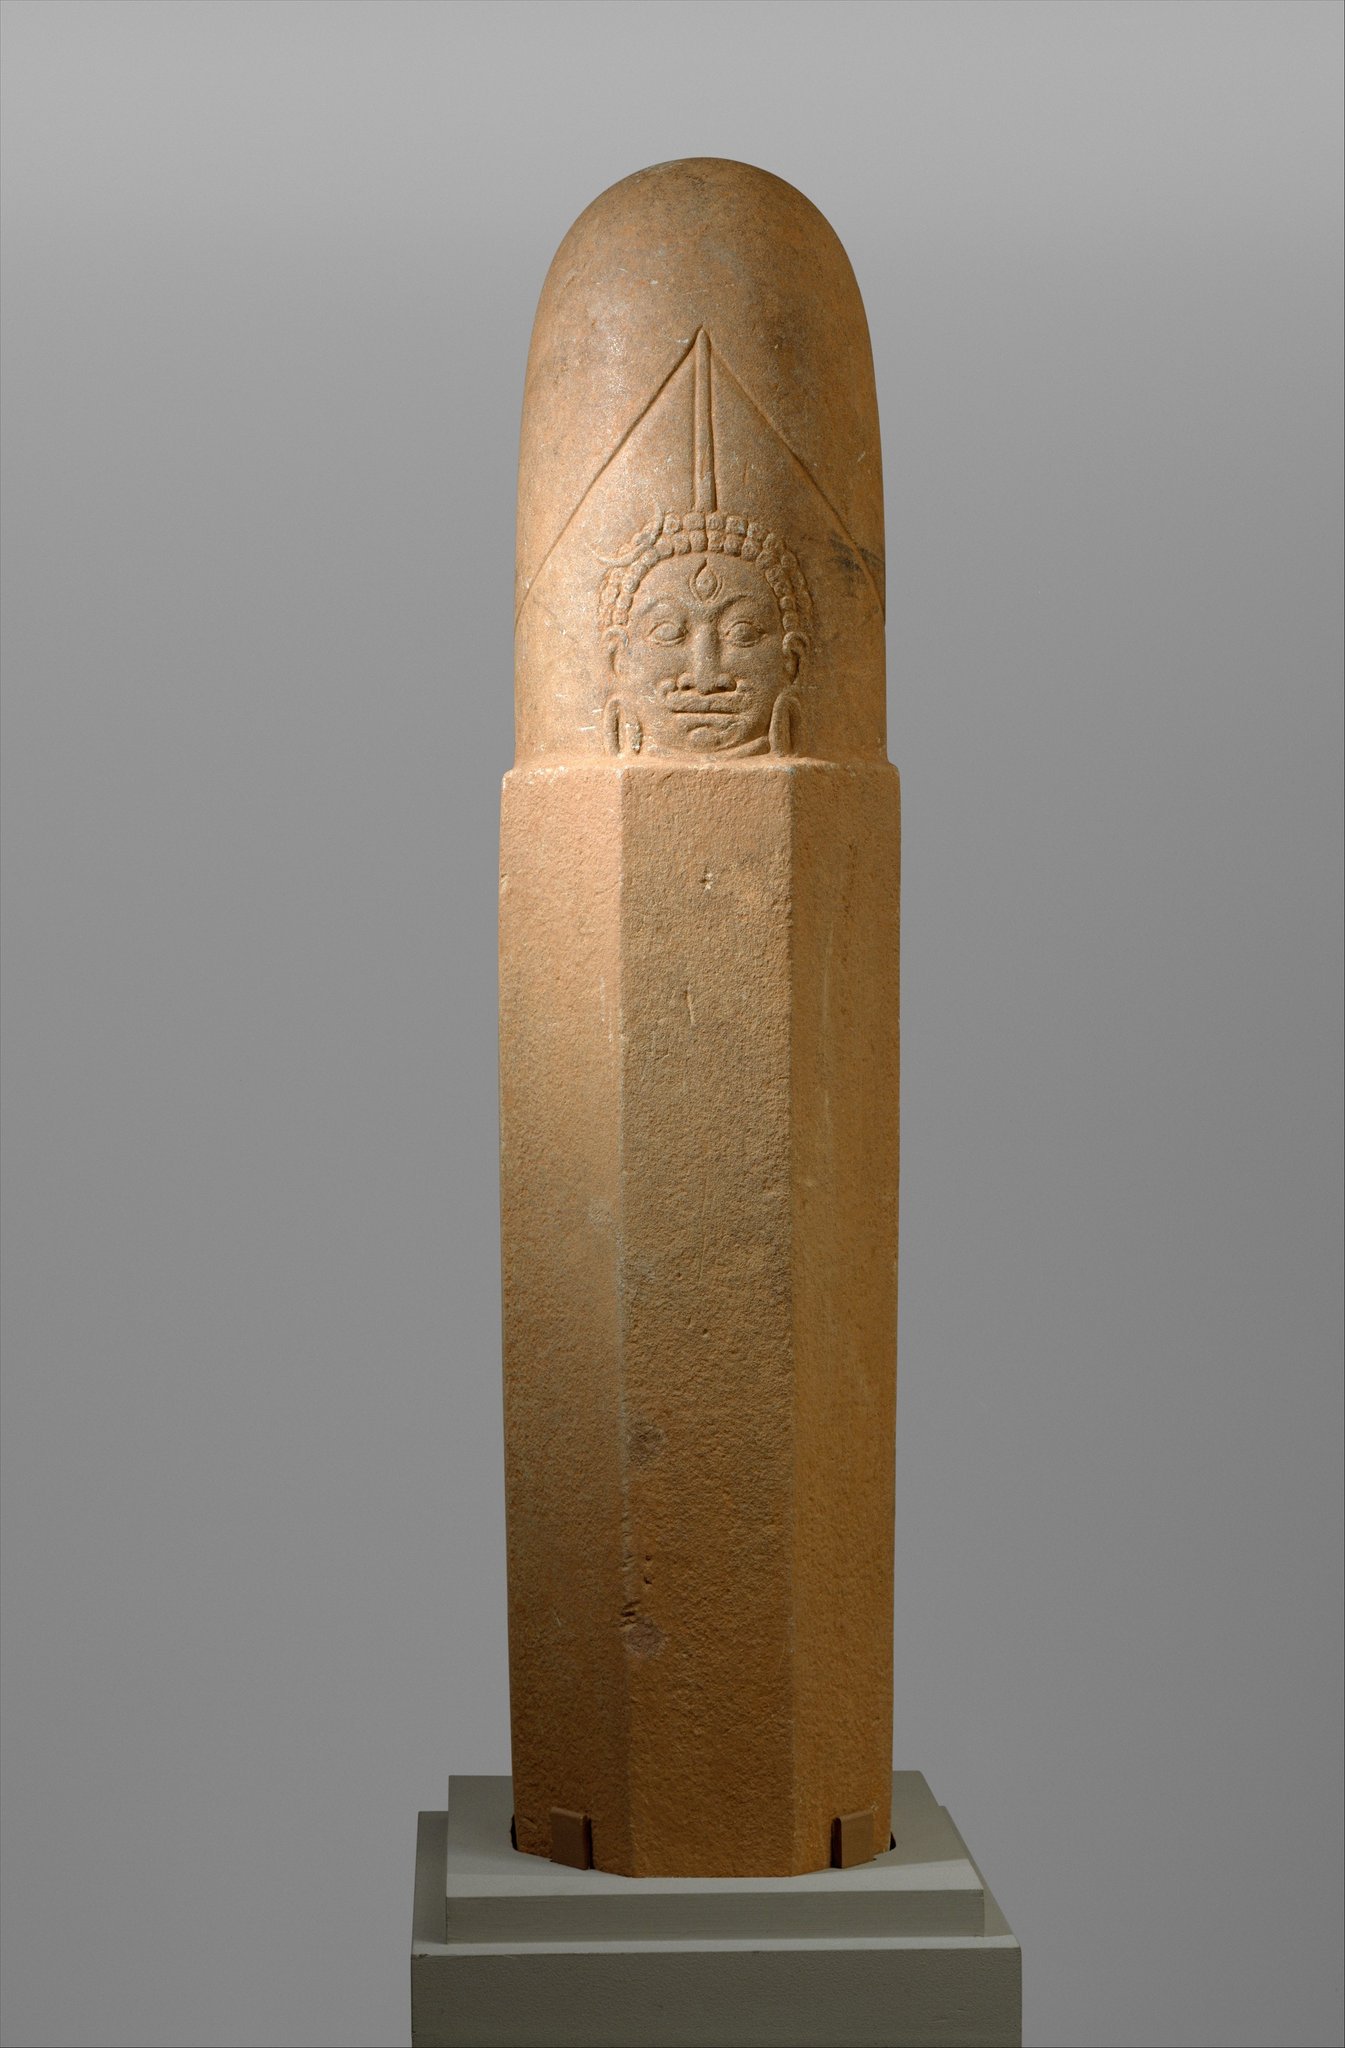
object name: statue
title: Linga with One Face of Shiva (Ekamukhalinga)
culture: thai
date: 601-733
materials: stone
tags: shiva